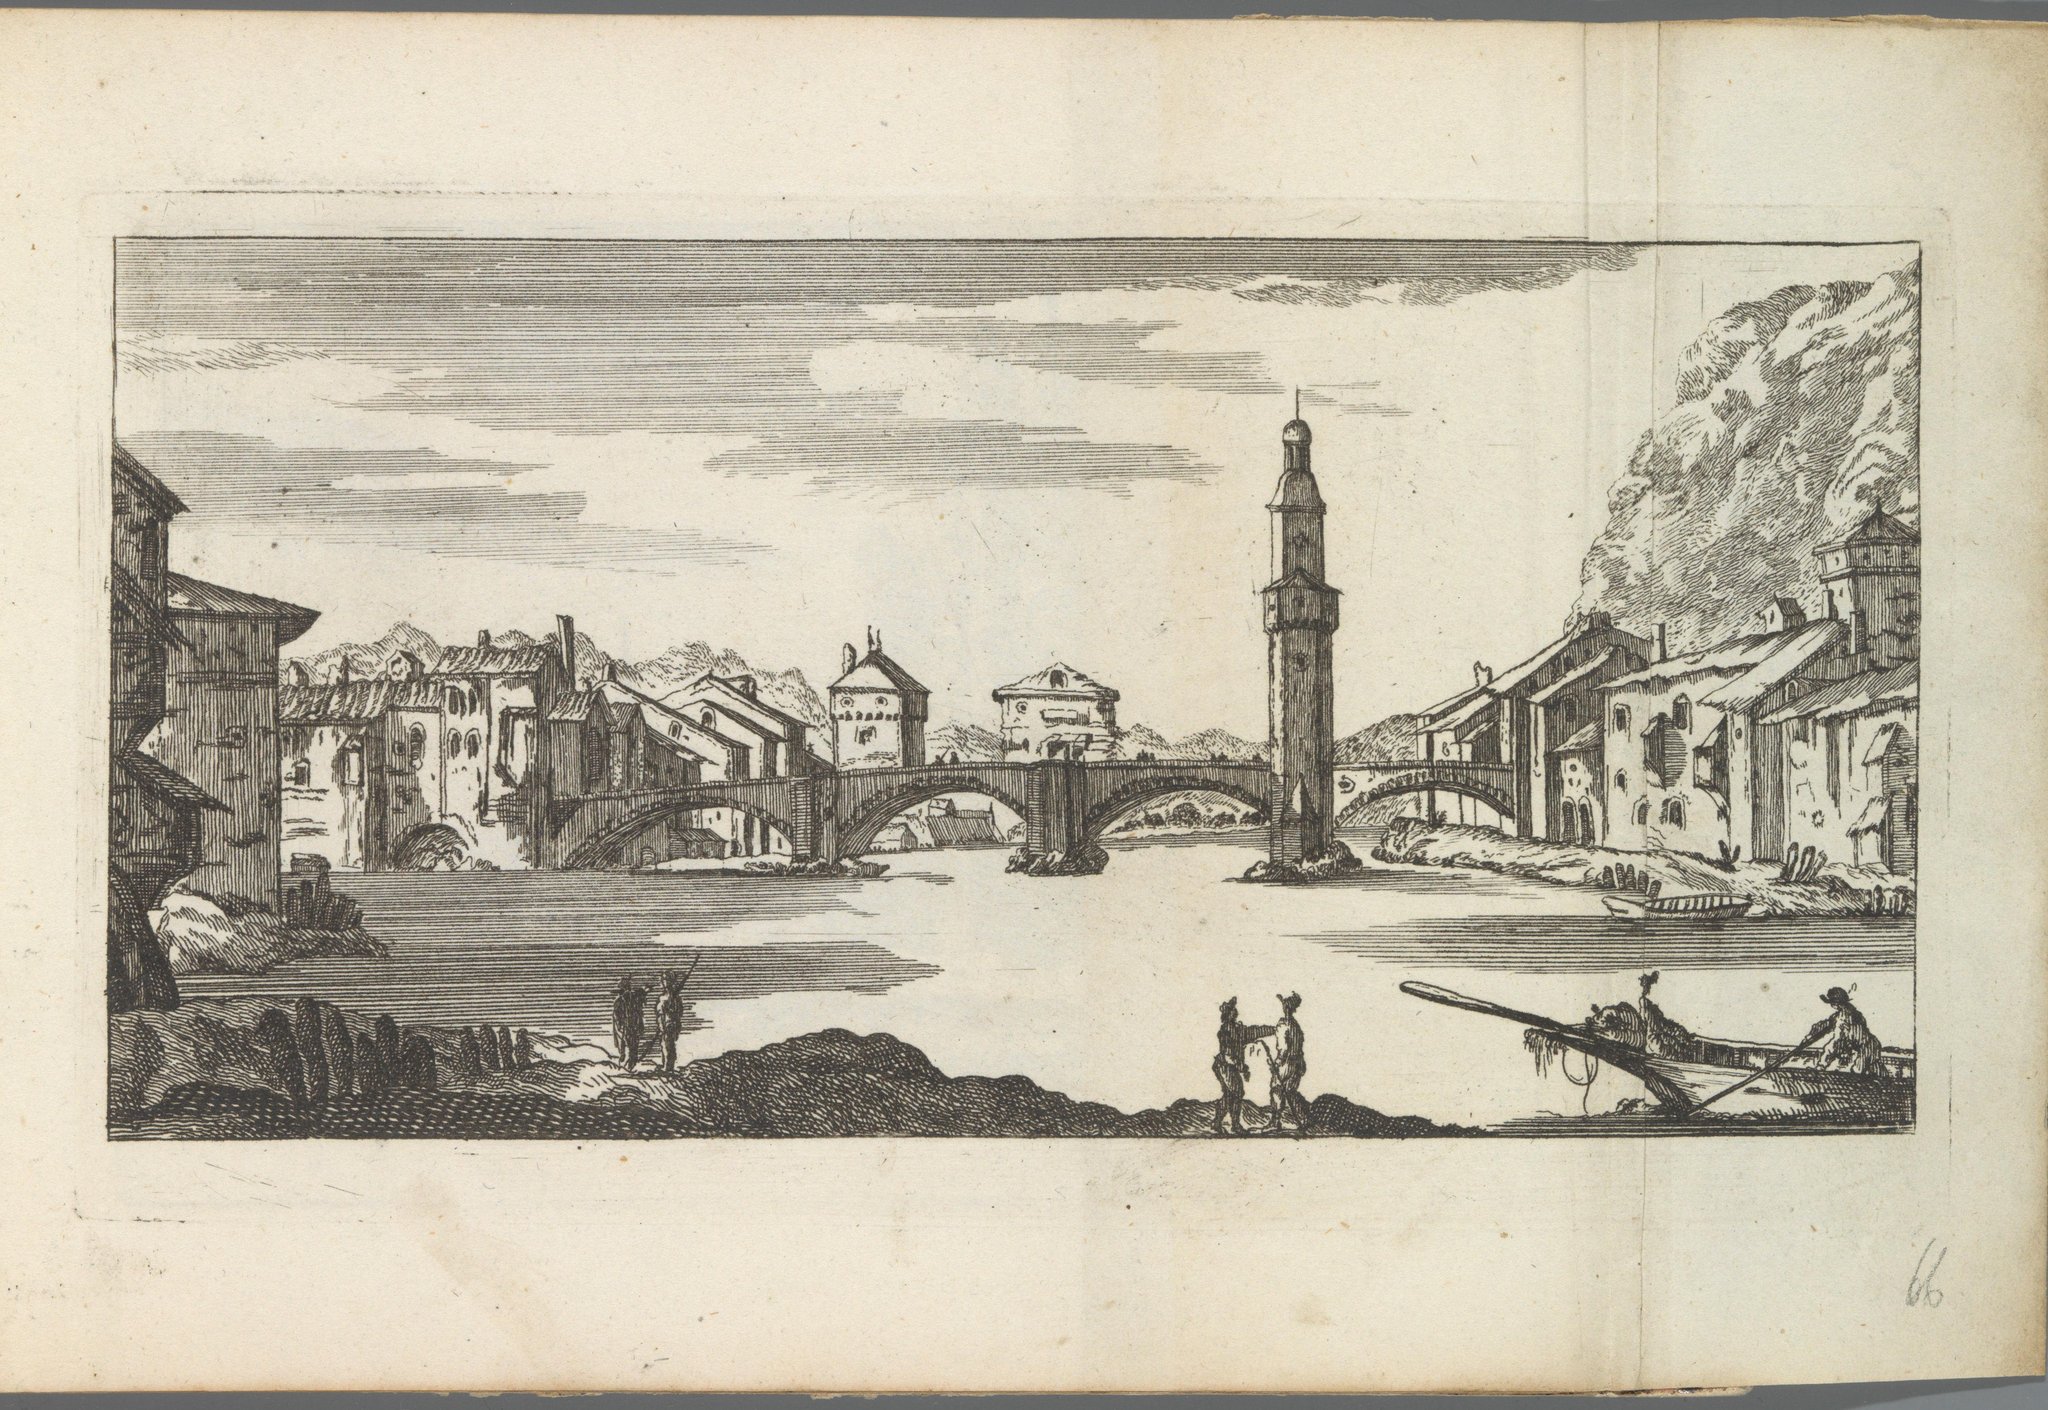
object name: print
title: Spiegel der natuur en school der teekenkunde (...)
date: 1600-1699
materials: paper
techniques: etching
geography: amsterdam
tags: landscapes, bridge in city across river, canal, etc.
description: Stadsgezicht met een brug. De brug heeft vier bogen en een toren. De prent maakt deel uit van een album.